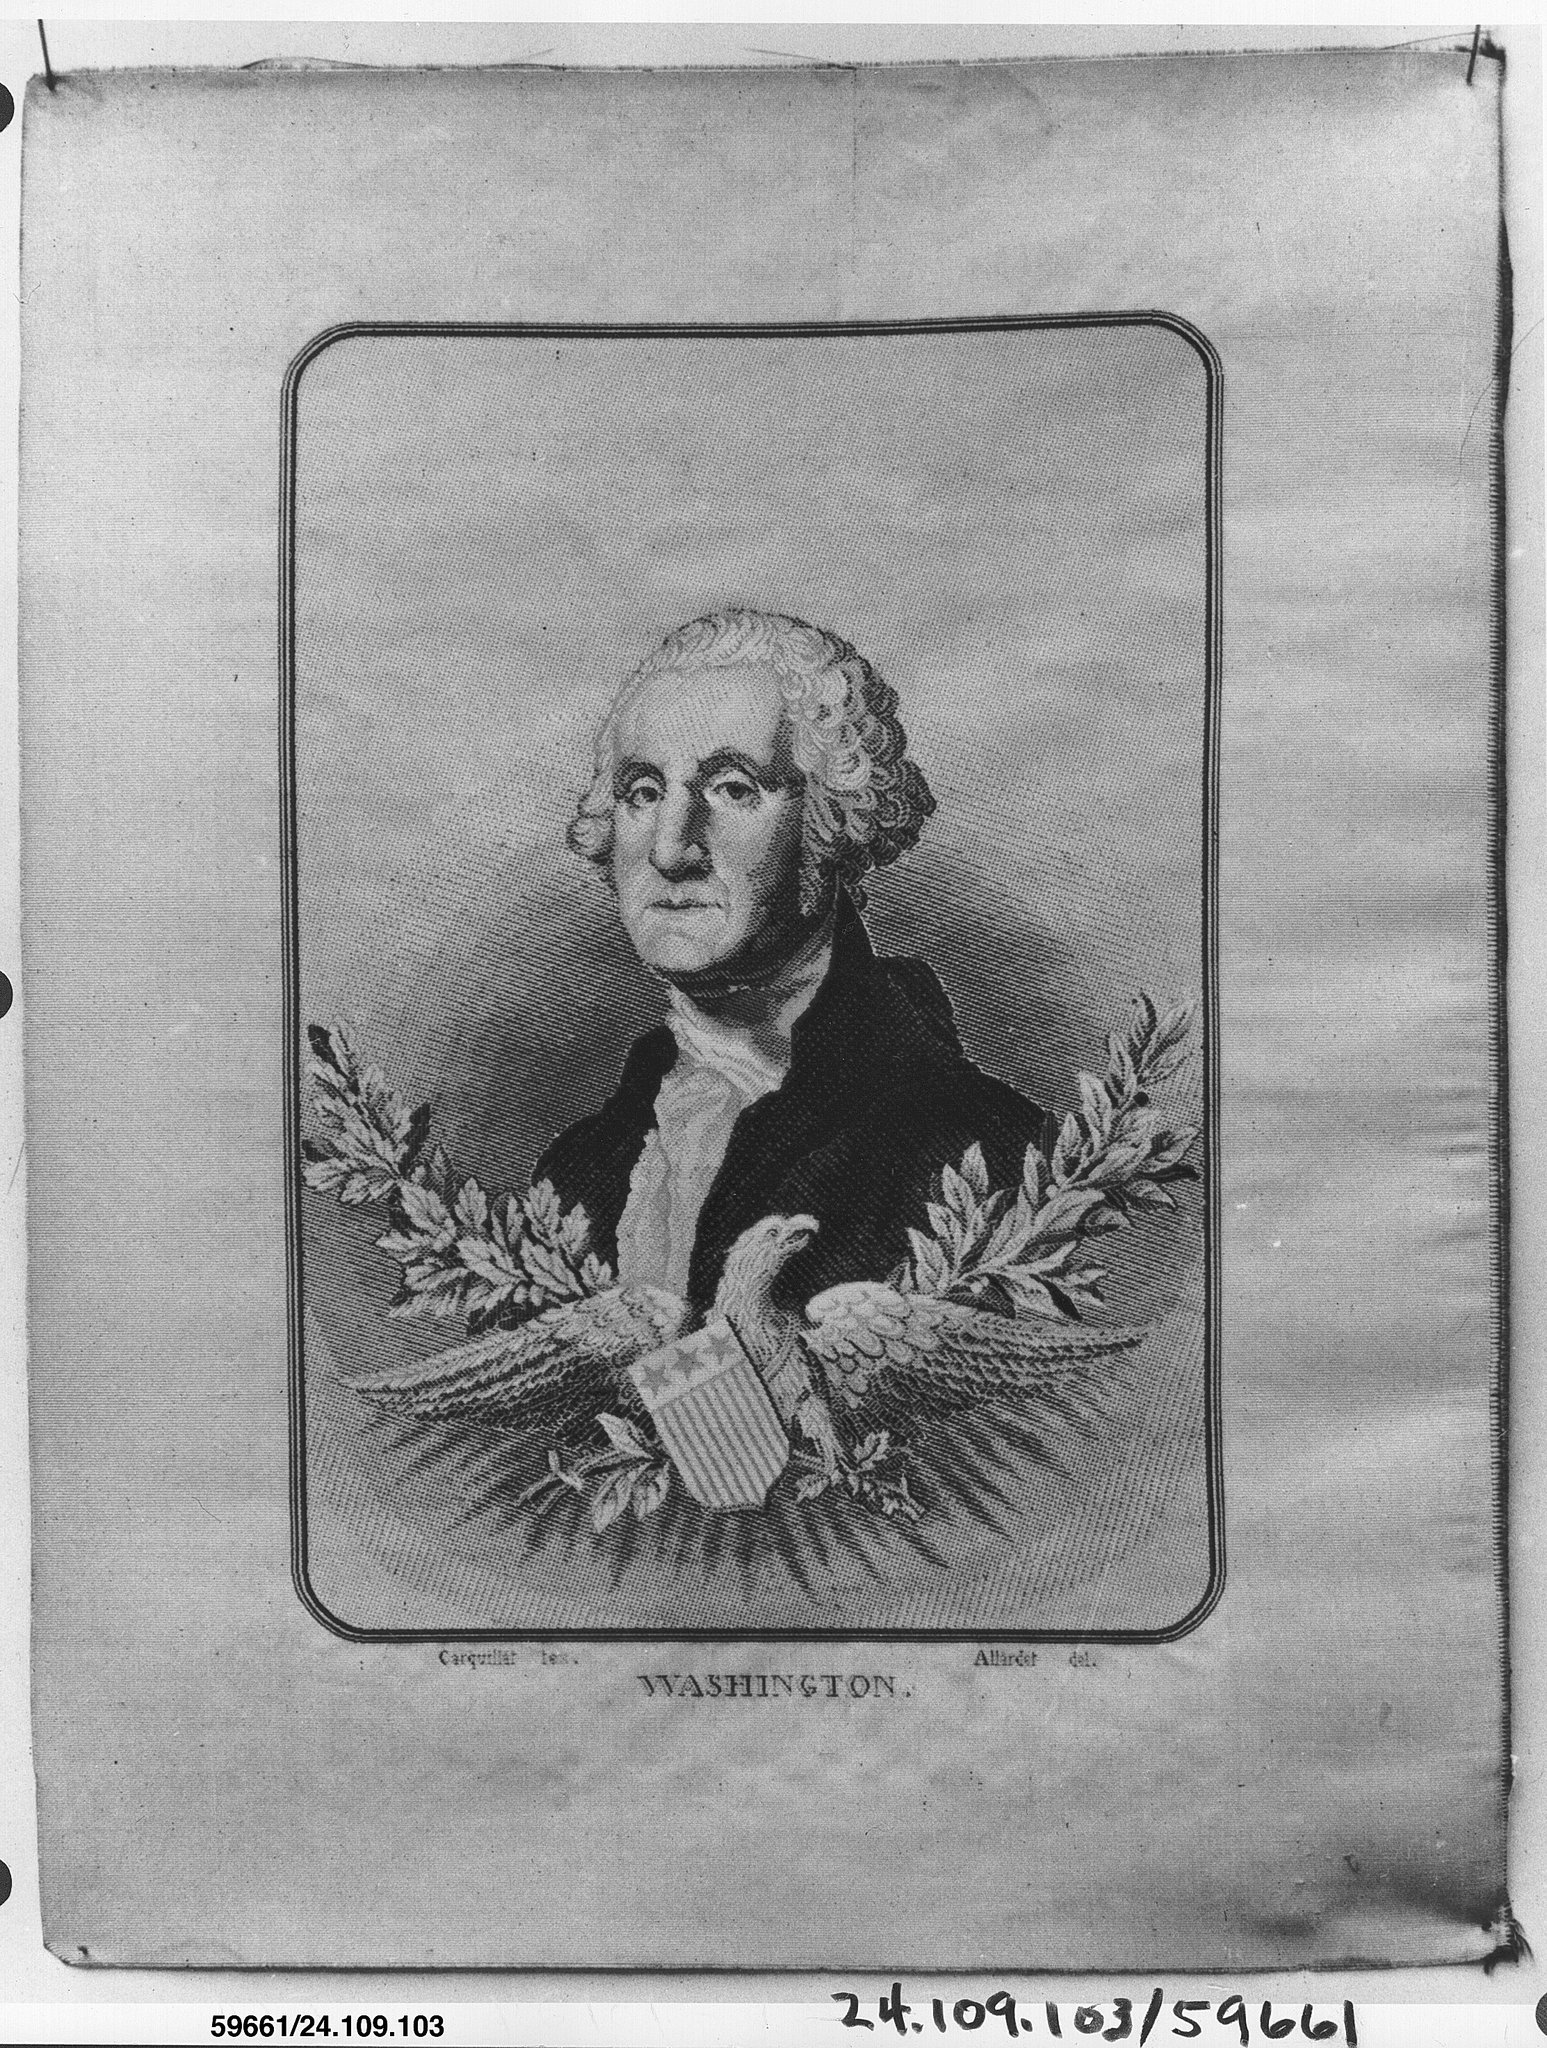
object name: portrait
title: George Washington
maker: jacques allardet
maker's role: designer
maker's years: 1800-1900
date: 1834-1866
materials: silk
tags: eagles,george washington,portraits,coat of arms